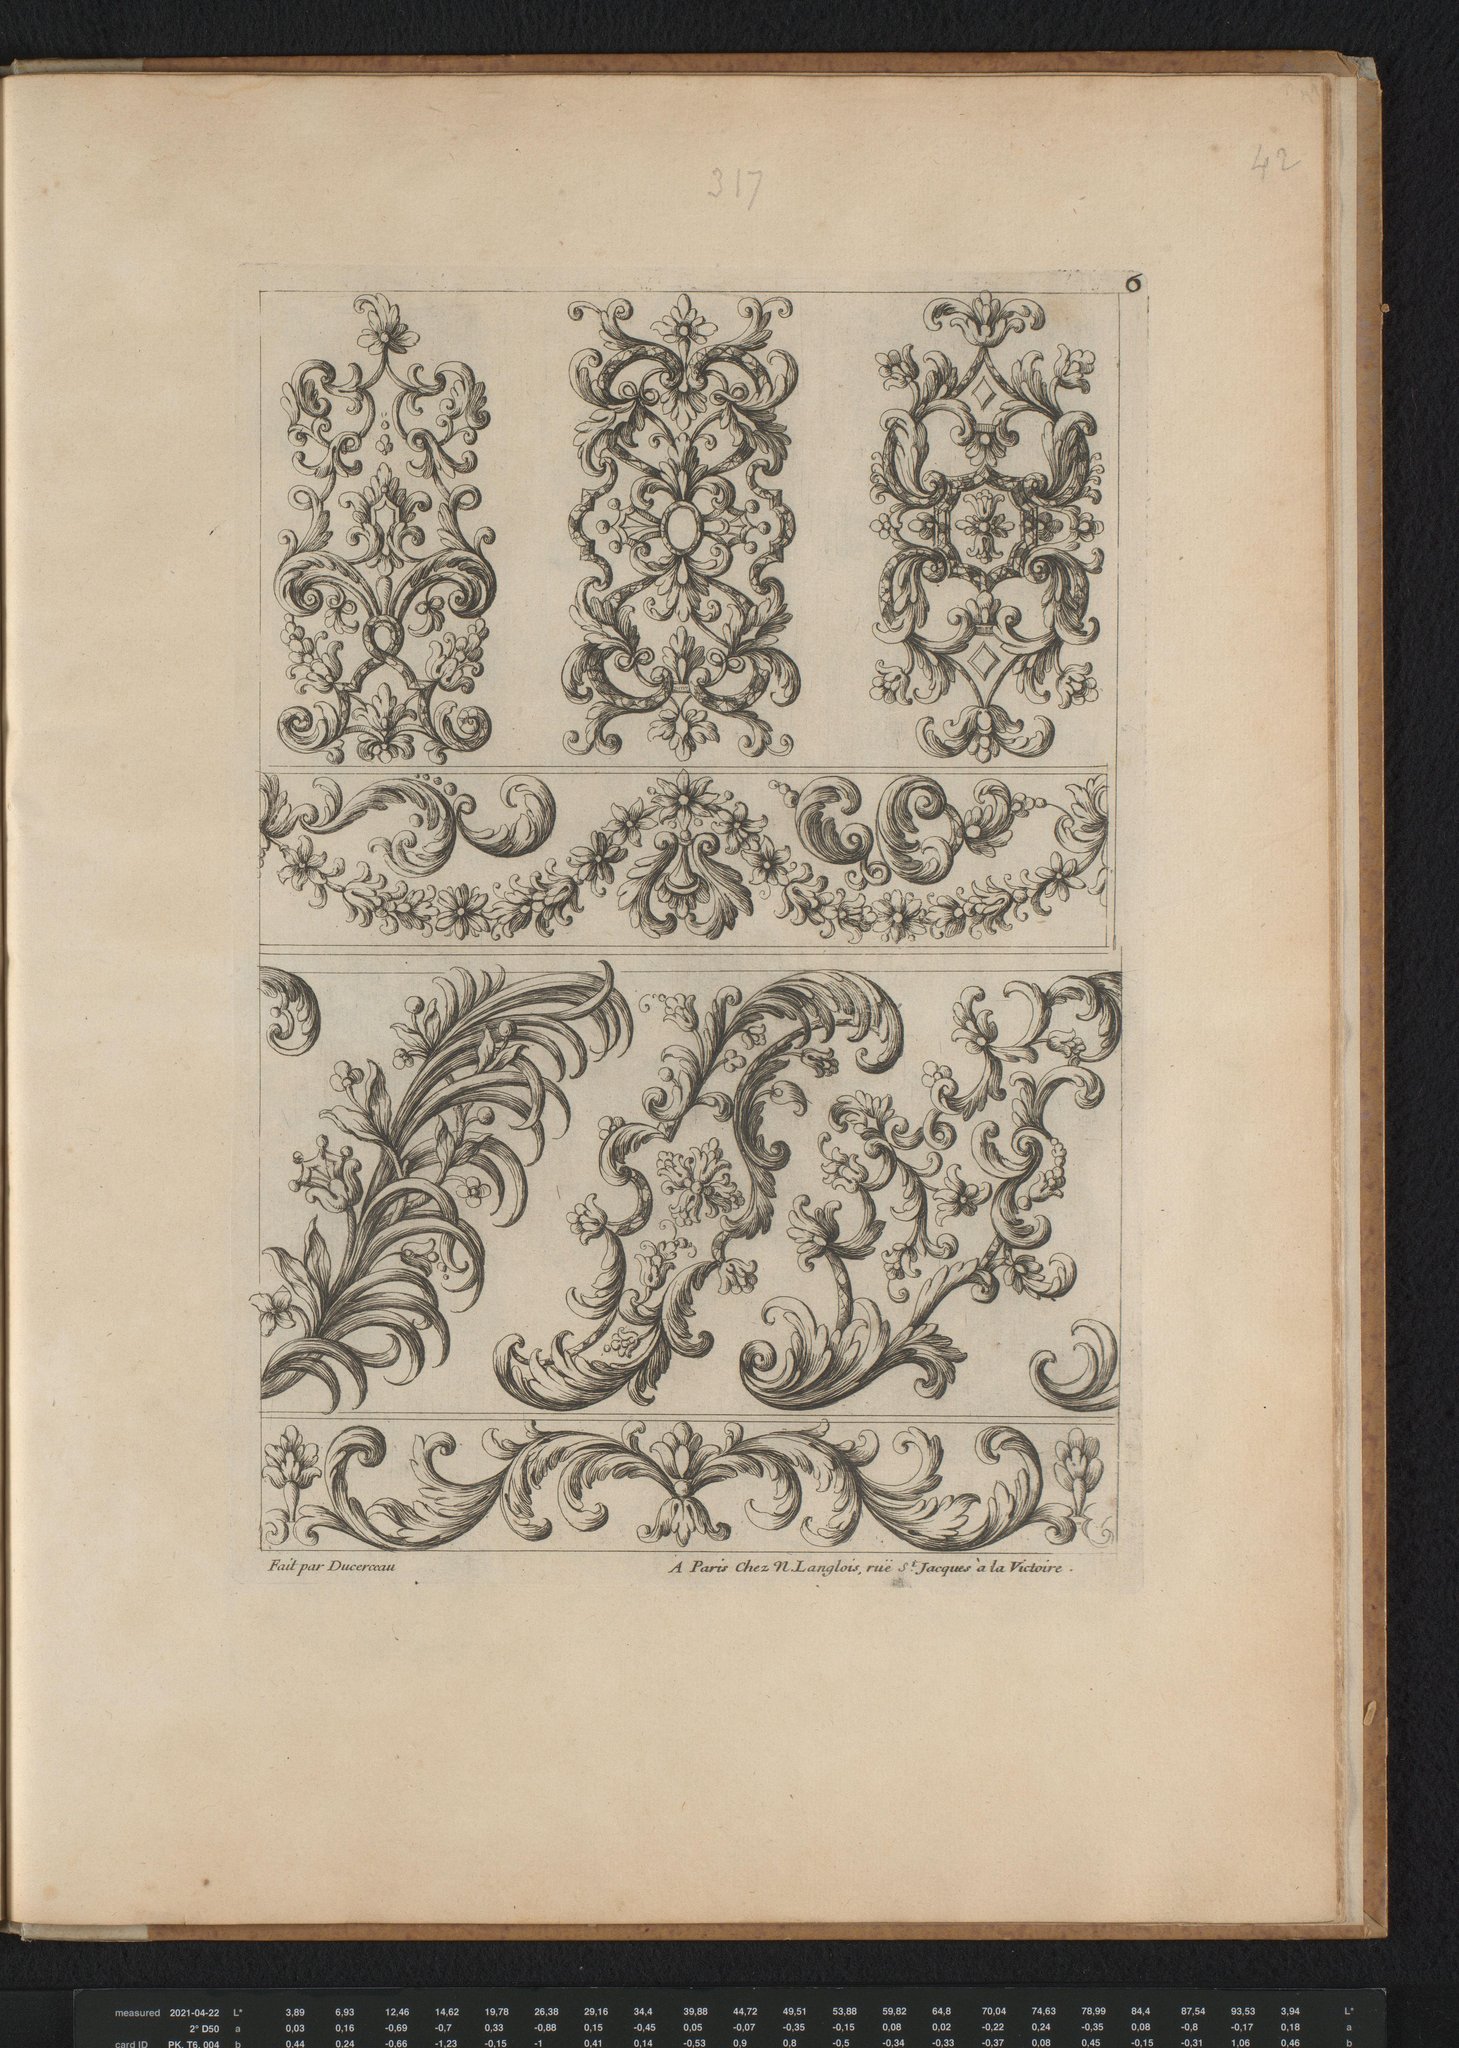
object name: ornament print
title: Ontwerpen voor borduurwerk op mannenkleding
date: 1670-1690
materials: paper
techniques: etching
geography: paris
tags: foliage, tendrils, branches ~ ornament, embroidery (ornamentation)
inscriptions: collector's mark: Lugt 2760, collector's mark: Lugt 2228a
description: Deze prent maakt deel uit van een album.